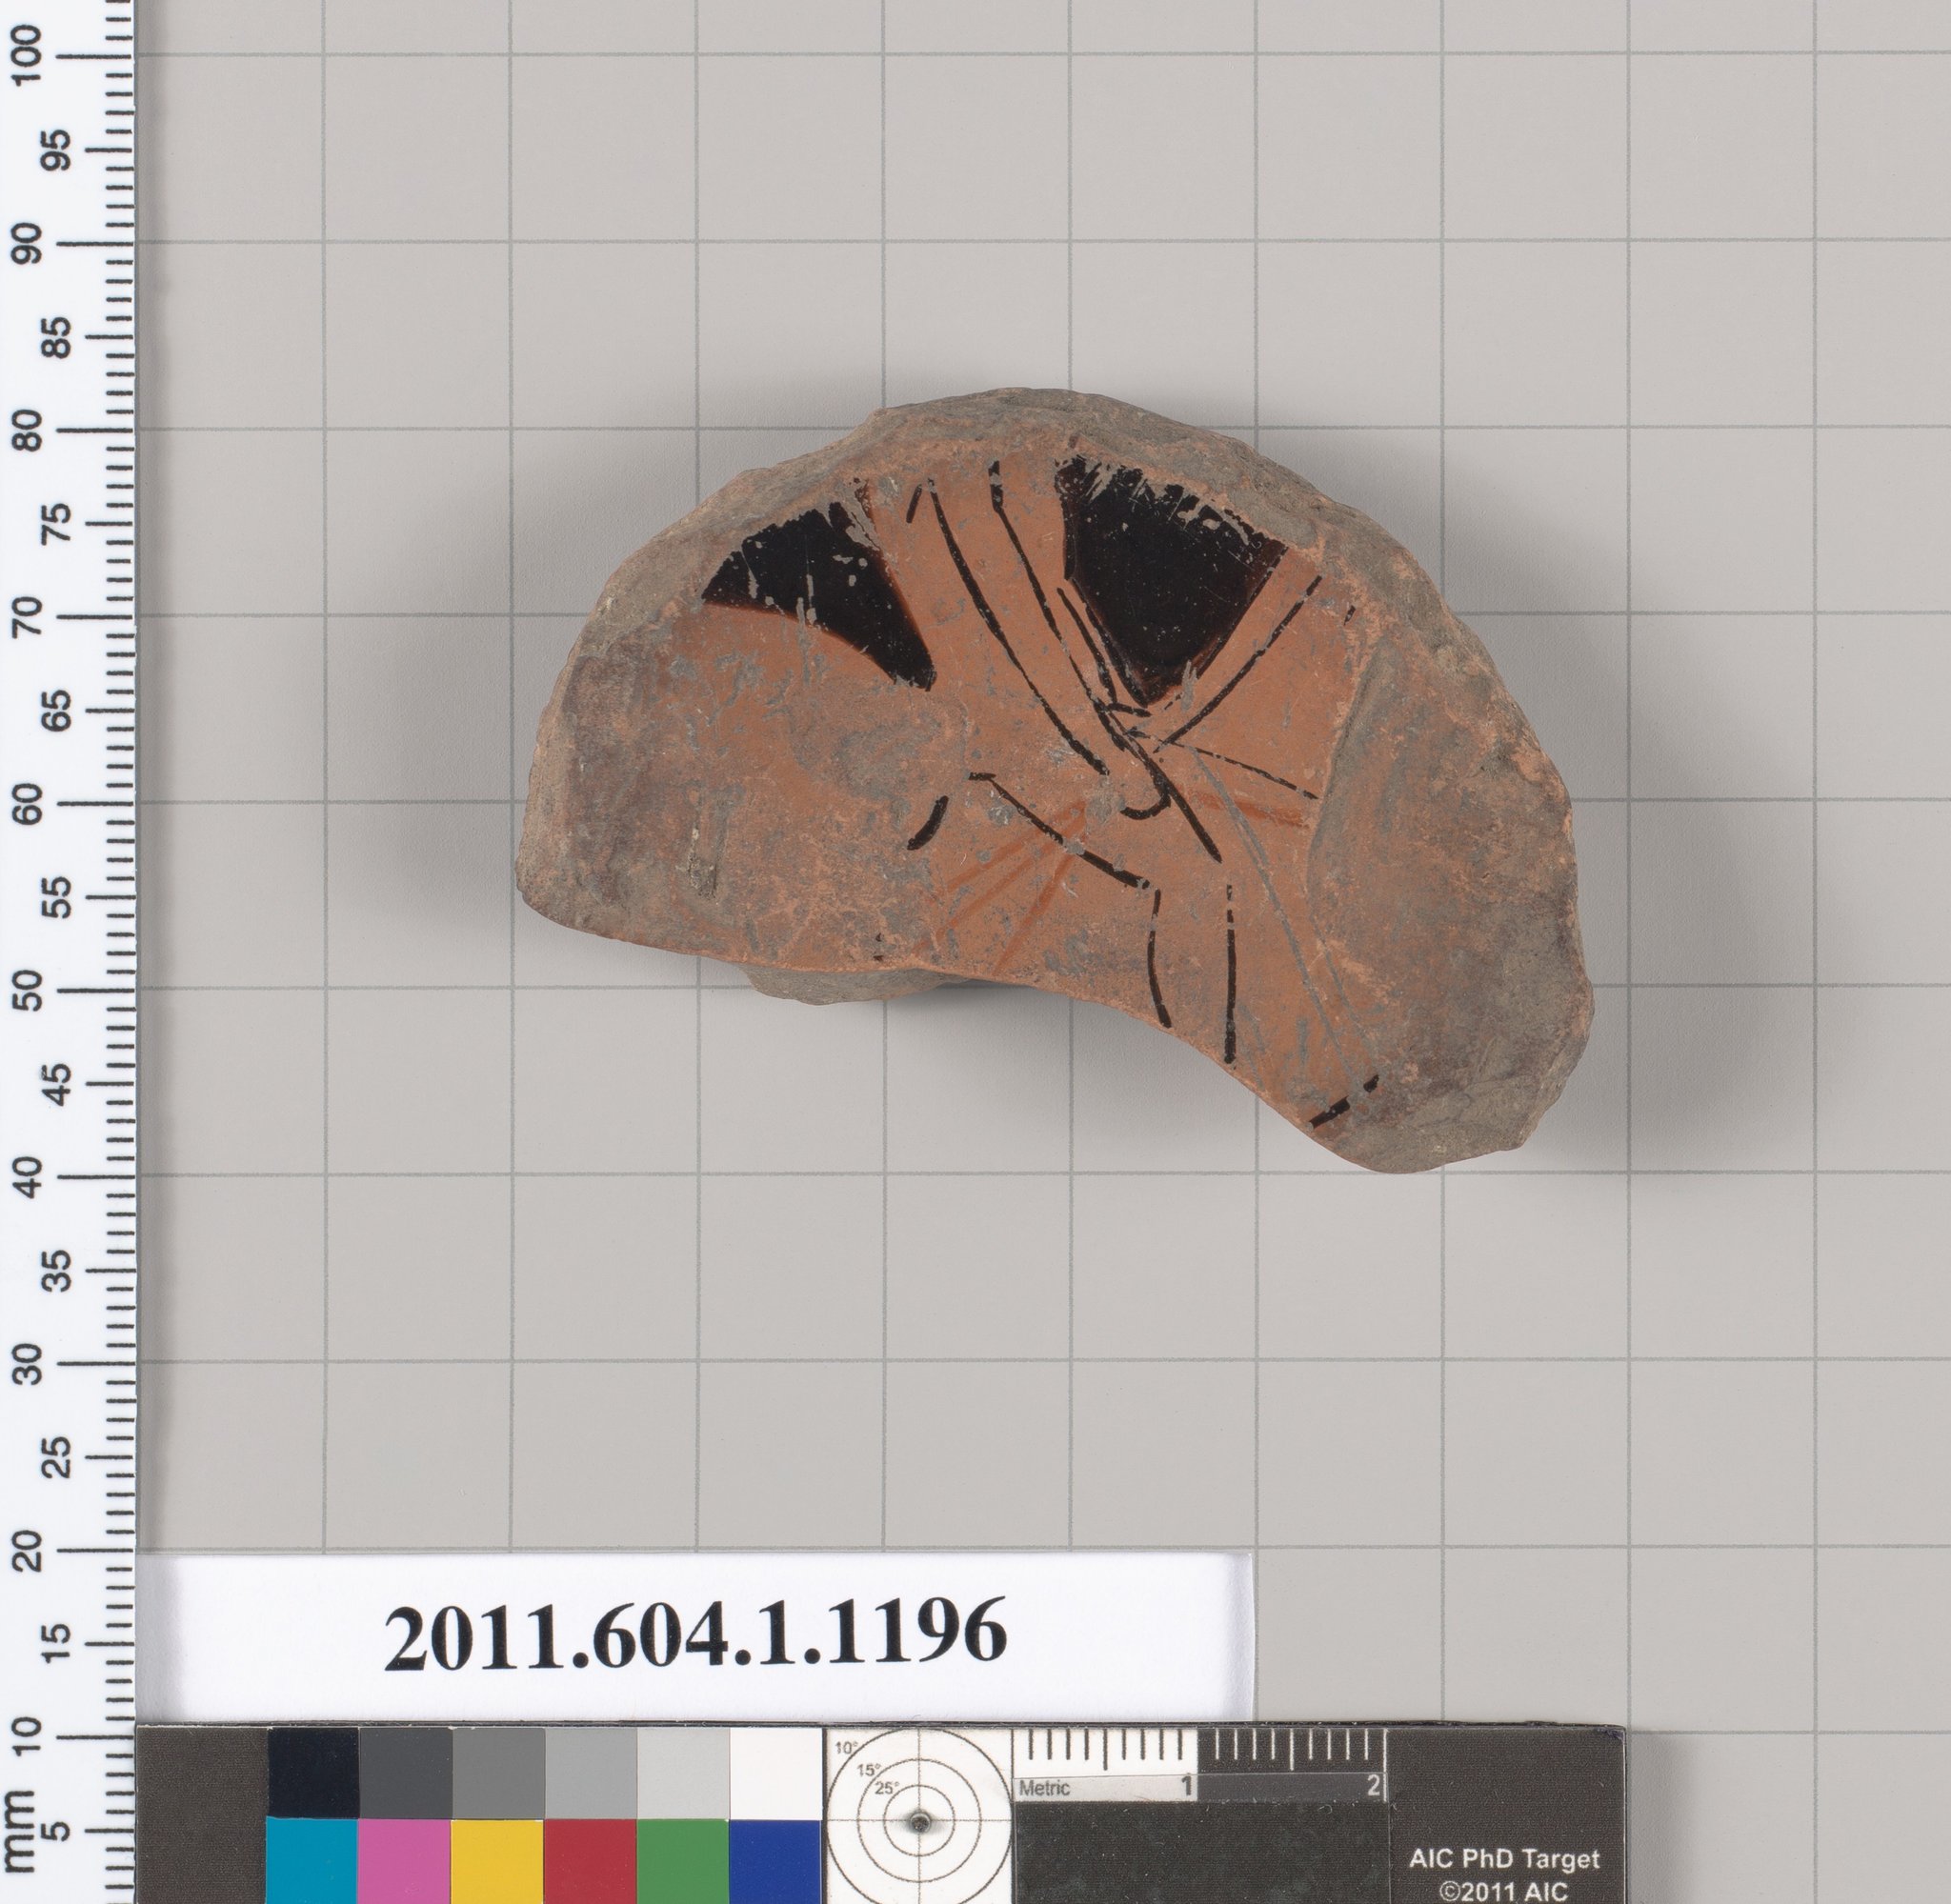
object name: kylix fragment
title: Terracotta fragment of a kylix (drinking cup)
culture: greek, attic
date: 475-451 BCE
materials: terracotta